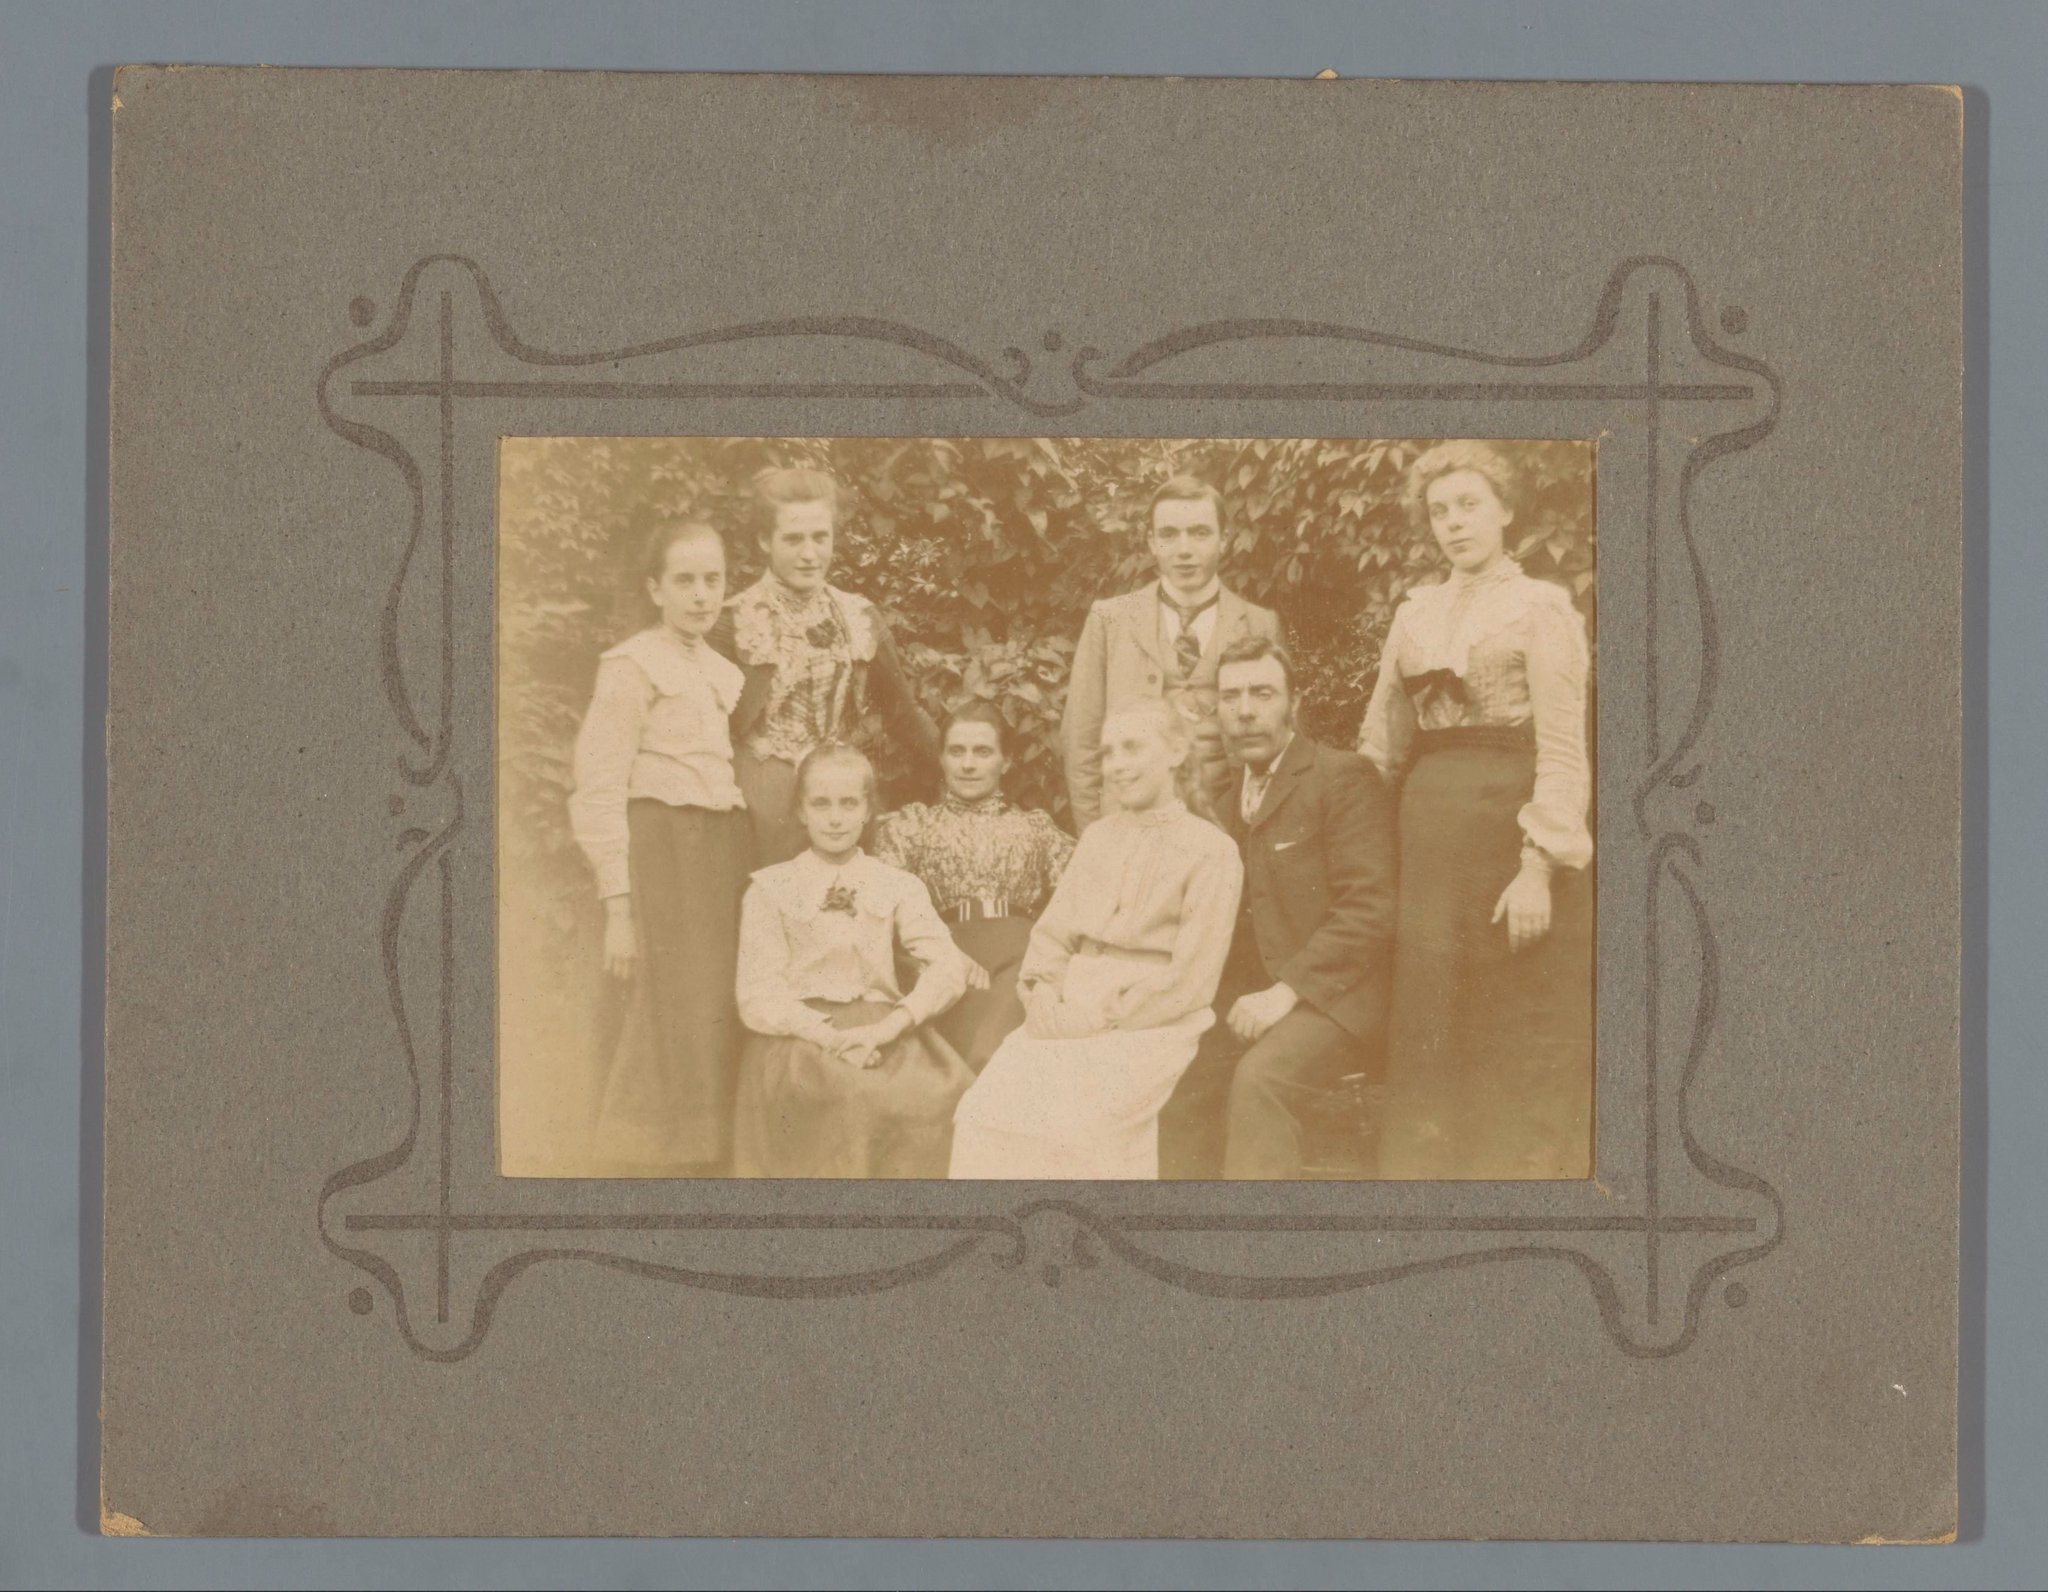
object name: photograph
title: Groepsportret van een onbekende familie in een tuin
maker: Anonymous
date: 1900-1915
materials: cardboard, photographic support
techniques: gelatin silver print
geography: netherlands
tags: family group, especially parents with their child(ren)